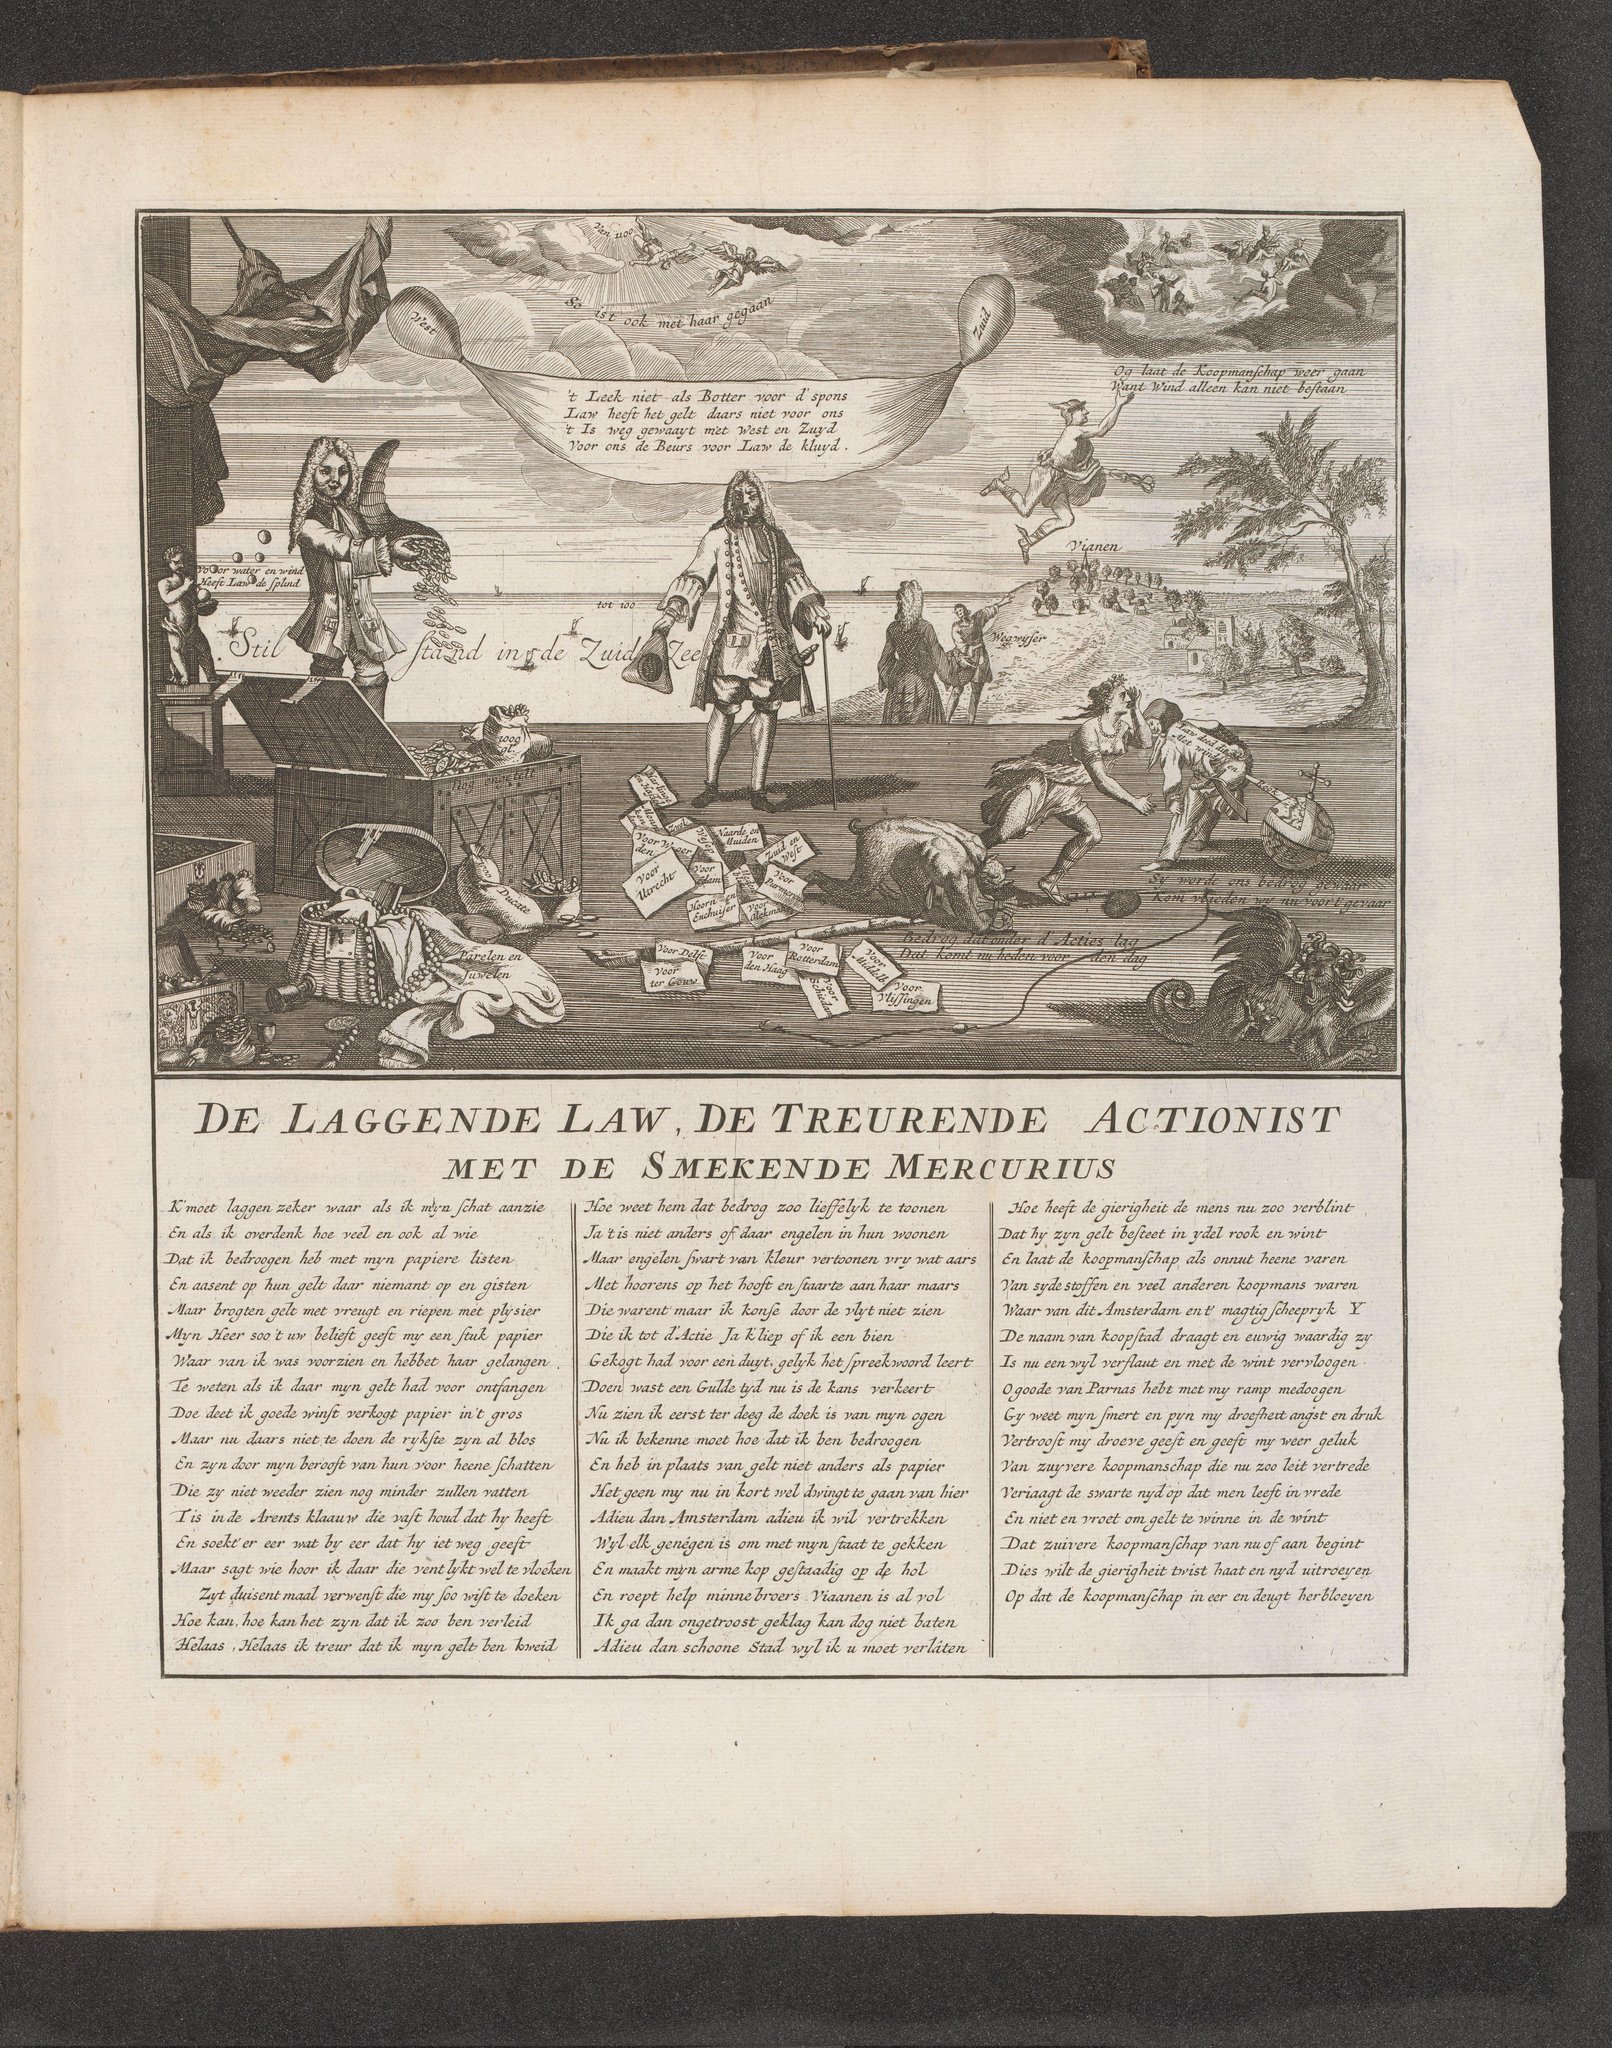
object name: cartoon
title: De Laggende Law, de Treurende Actonist met de Smekende Mercurius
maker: Anonymous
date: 1720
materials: paper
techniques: etching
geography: northern netherlands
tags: econoom, john law, vianen, windhandel van 1720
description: Toneel met de Lachende Law, de Treurende Actonist en de Smekende Mercurius. Links vult een lachende John Law zijn geldkist, in het midden een wanhopige windhandelaar, rechts smeekt Mercurius de goden om herstel van het Koopmanschap. Op de achtergrond verwijzingen naar de projecten in de Zuidzee en te Vianen. Op de voorgrond duivels, actiebriefjes, etc. Met onderschrift in drie kolommen. Prent in de gebonden vierde uitgave (304 B 12) van Het Groote Tafereel der Dwaasheid met spotprenten op de Windhandel of Actiehandel van 1720.